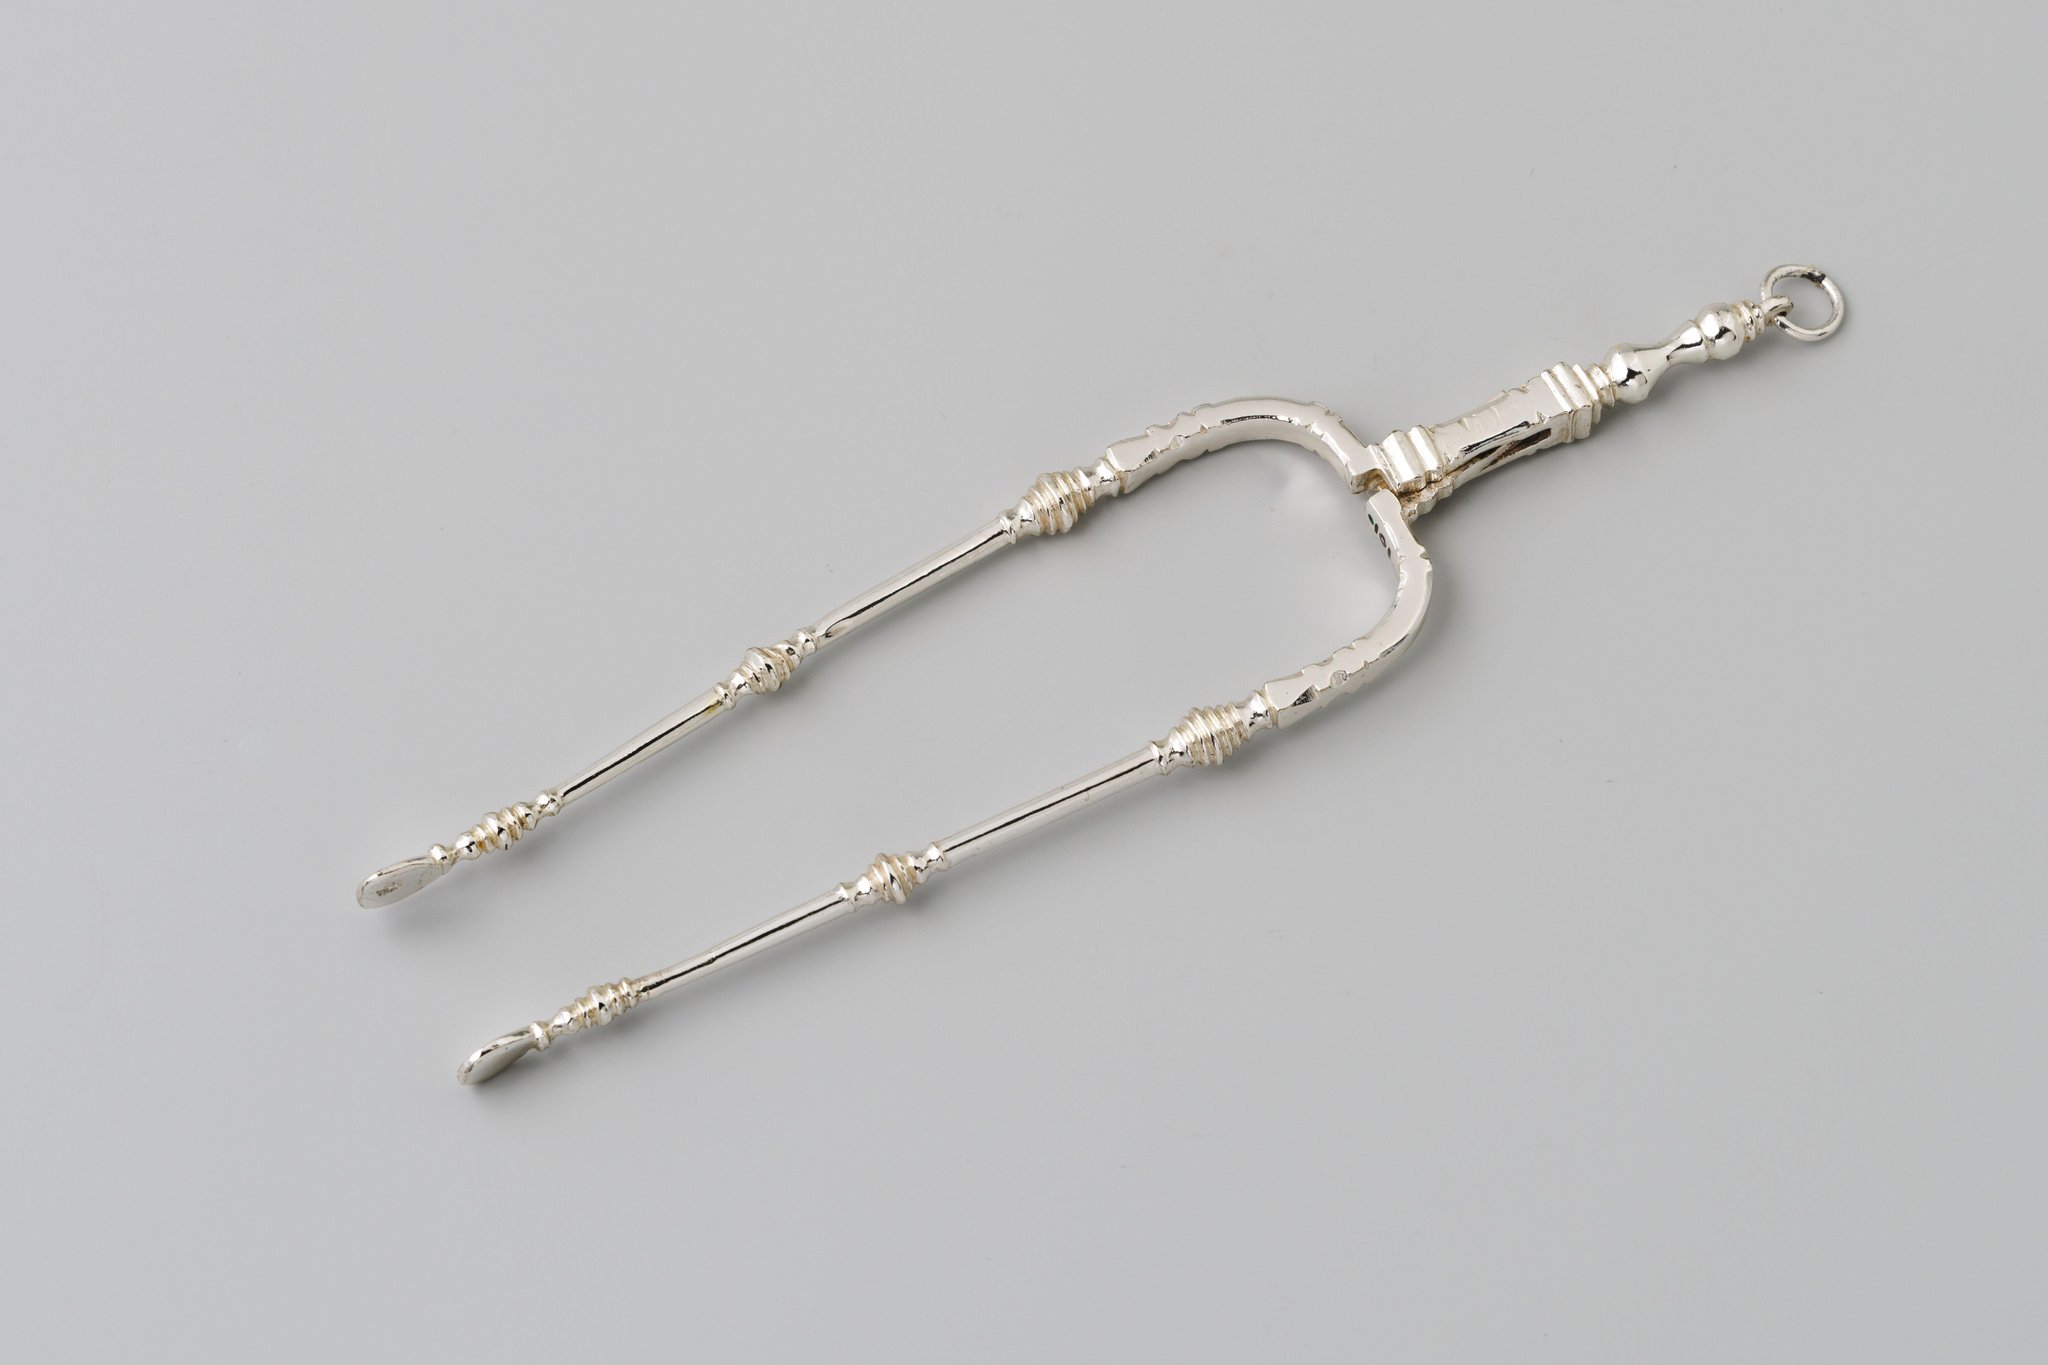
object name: miniature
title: Vuurtang van zilver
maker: wessel jansen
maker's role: silversmith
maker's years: -1696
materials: silver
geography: amsterdam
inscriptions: maker's mark: ‘W (Citroen 1975, nr. 903)’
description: Vuurtang van zilver met geprofileerde stelen en ring.